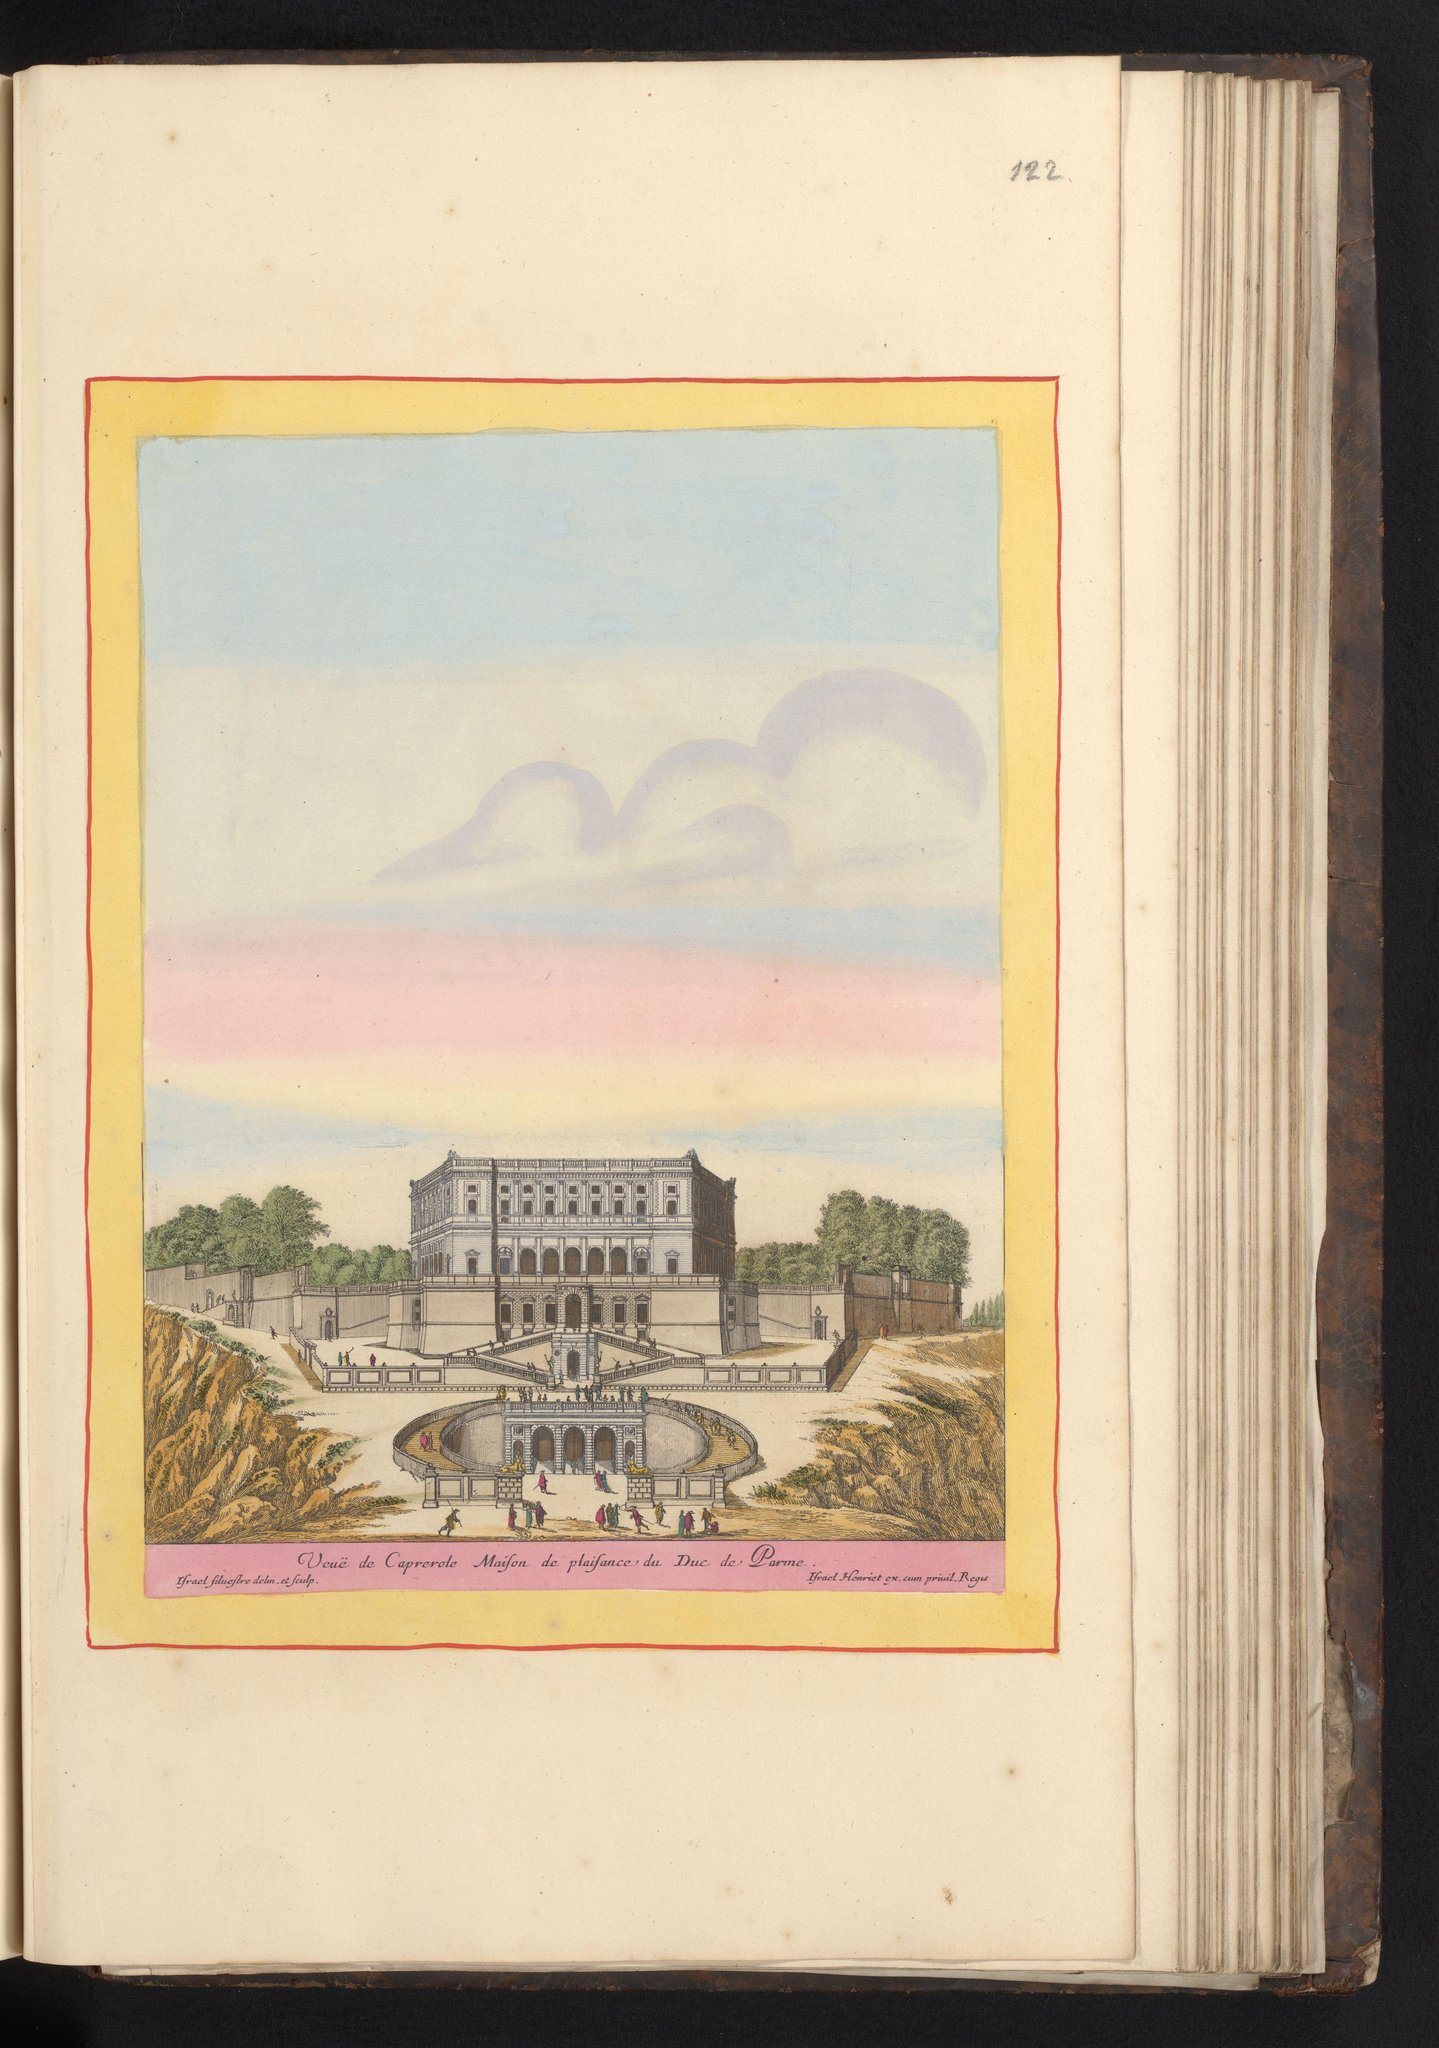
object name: album leaf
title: Gezichten op Italië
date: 1631-1691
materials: paper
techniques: colour, etching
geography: paris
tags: city-view, and landscape with man-made constructions, villa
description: Prent maakt deel uit van een reeks van 15 prenten (+ titelprent) met gezichten op Italië. De prent is langs de bovenrand van de voorstelling afgescheurd. De voorstelling is aan de bovenzijde aangevuld met een geschilderde lucht.